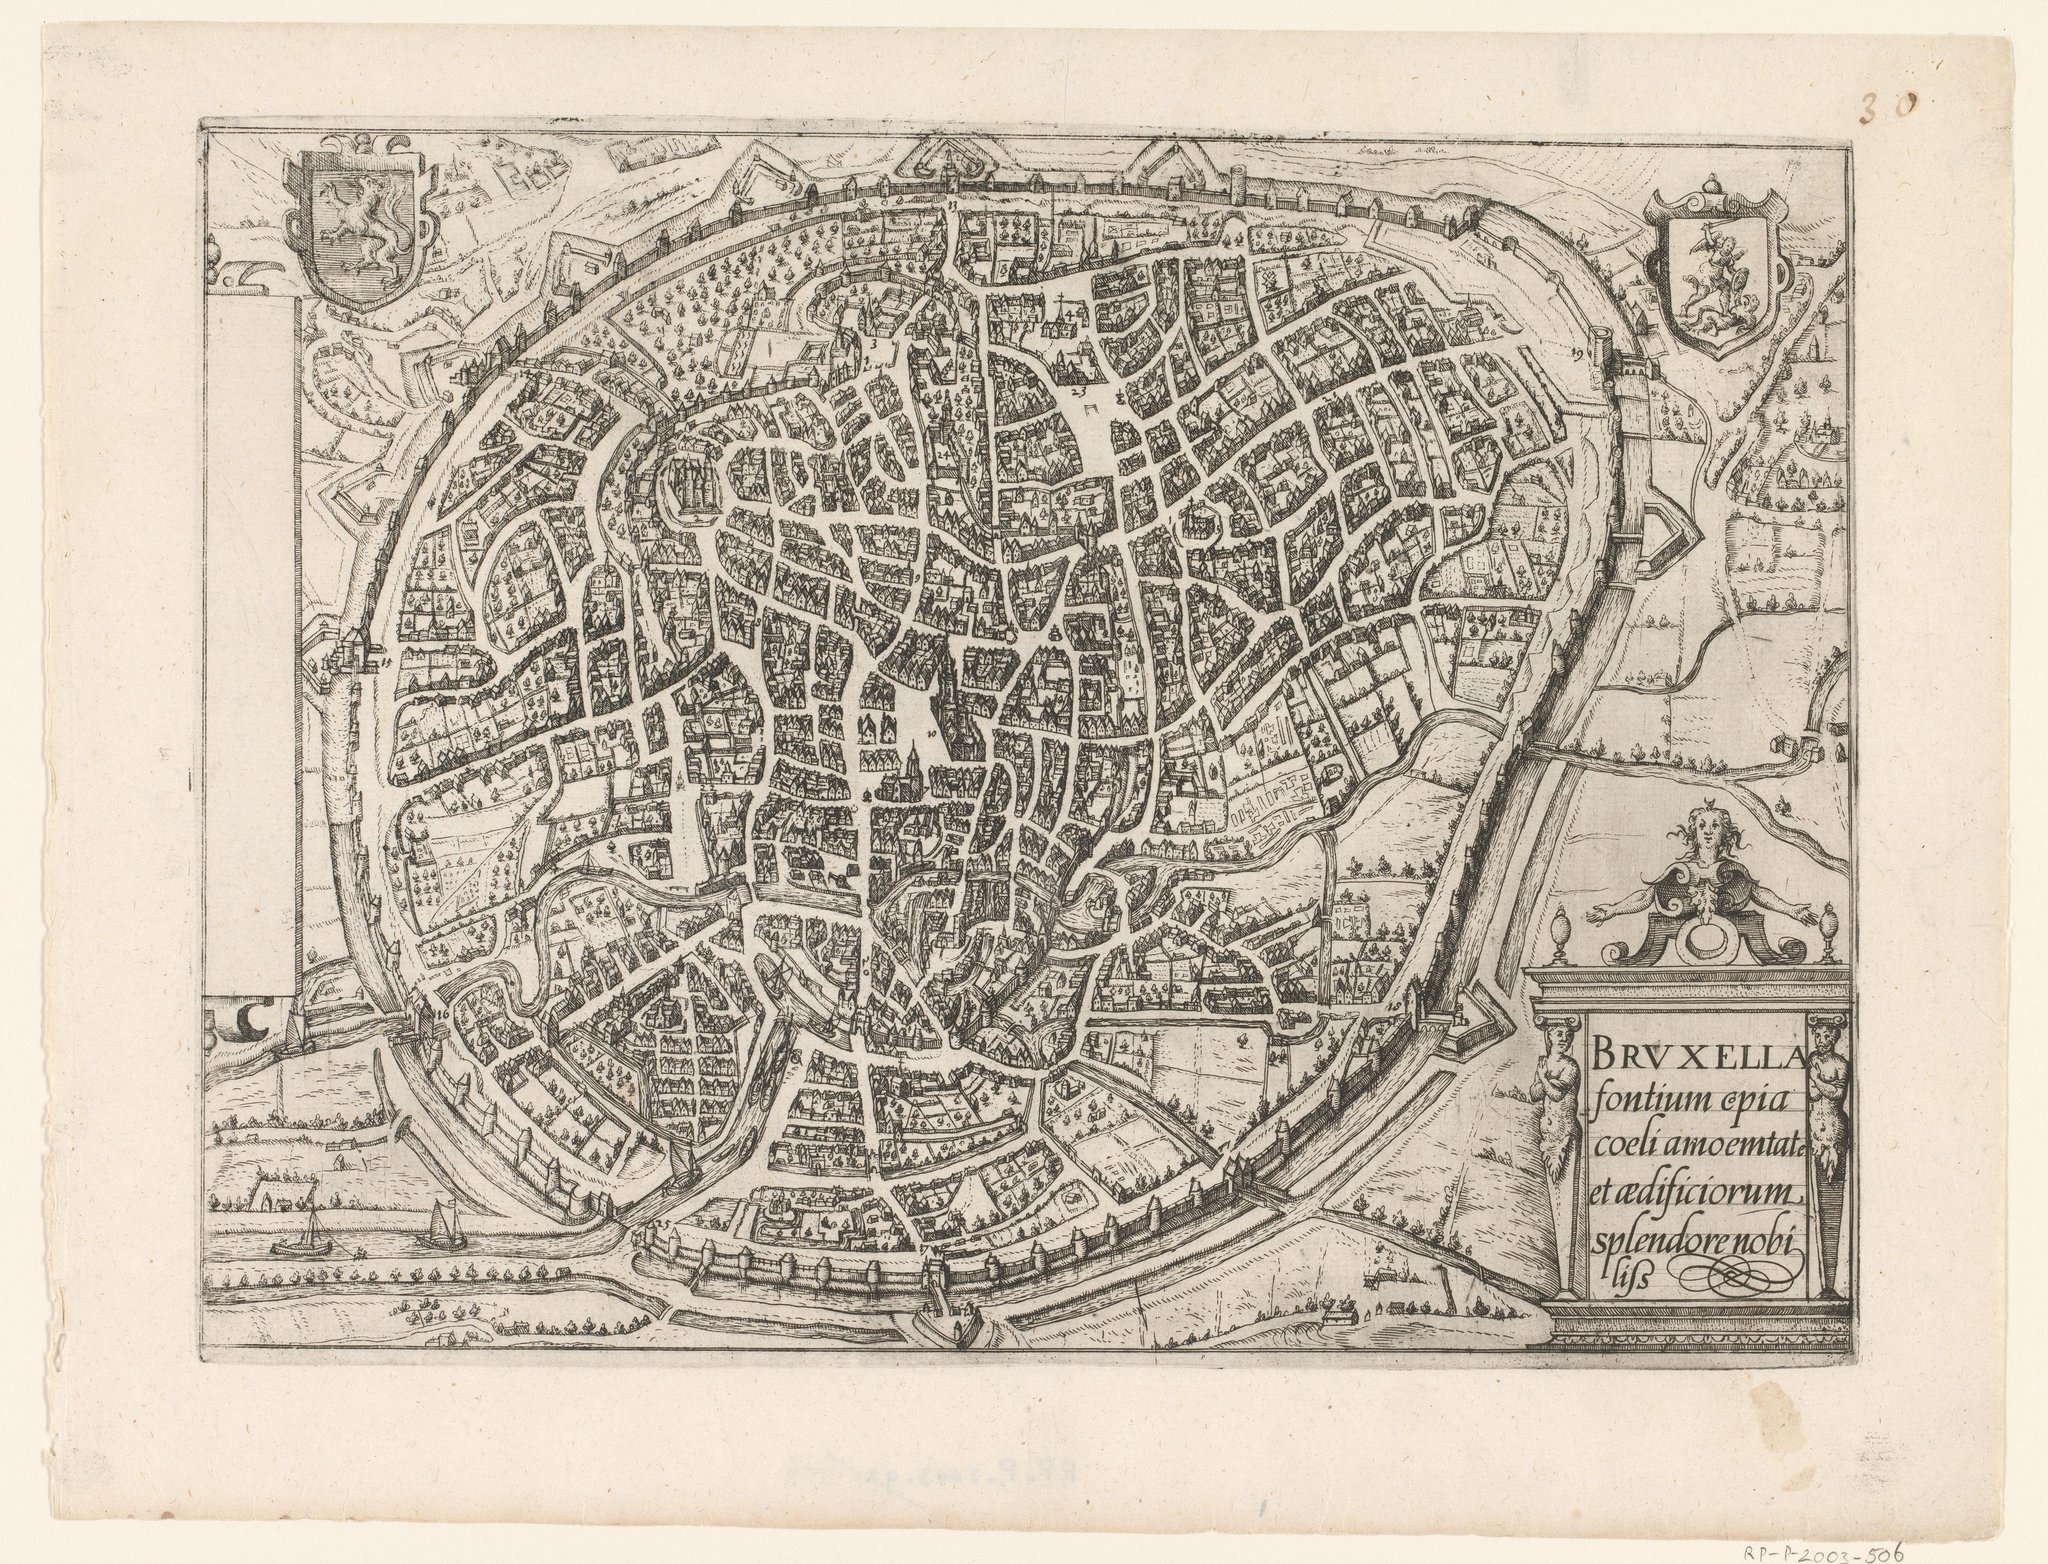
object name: area plan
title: Plattegrond van Brussel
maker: Anonymous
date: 1607-1609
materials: paper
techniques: etching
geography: northern netherlands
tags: maps of cities, brussels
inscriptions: number: ‘30’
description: Plattegrond van de stad Brussel (Bruxelles). Linksboven het wapen van Brabant, rechtsboven het stadswapen. Rechtsonder een cartouche met hermen en de Latijnse titel. Links een deel van een blanco cartouche. Onderdeel van de verzameling kaarten genomen uit een latere editie van: Descrittione di tutti i Paesi Bassi van Lodovico Guicciardini.